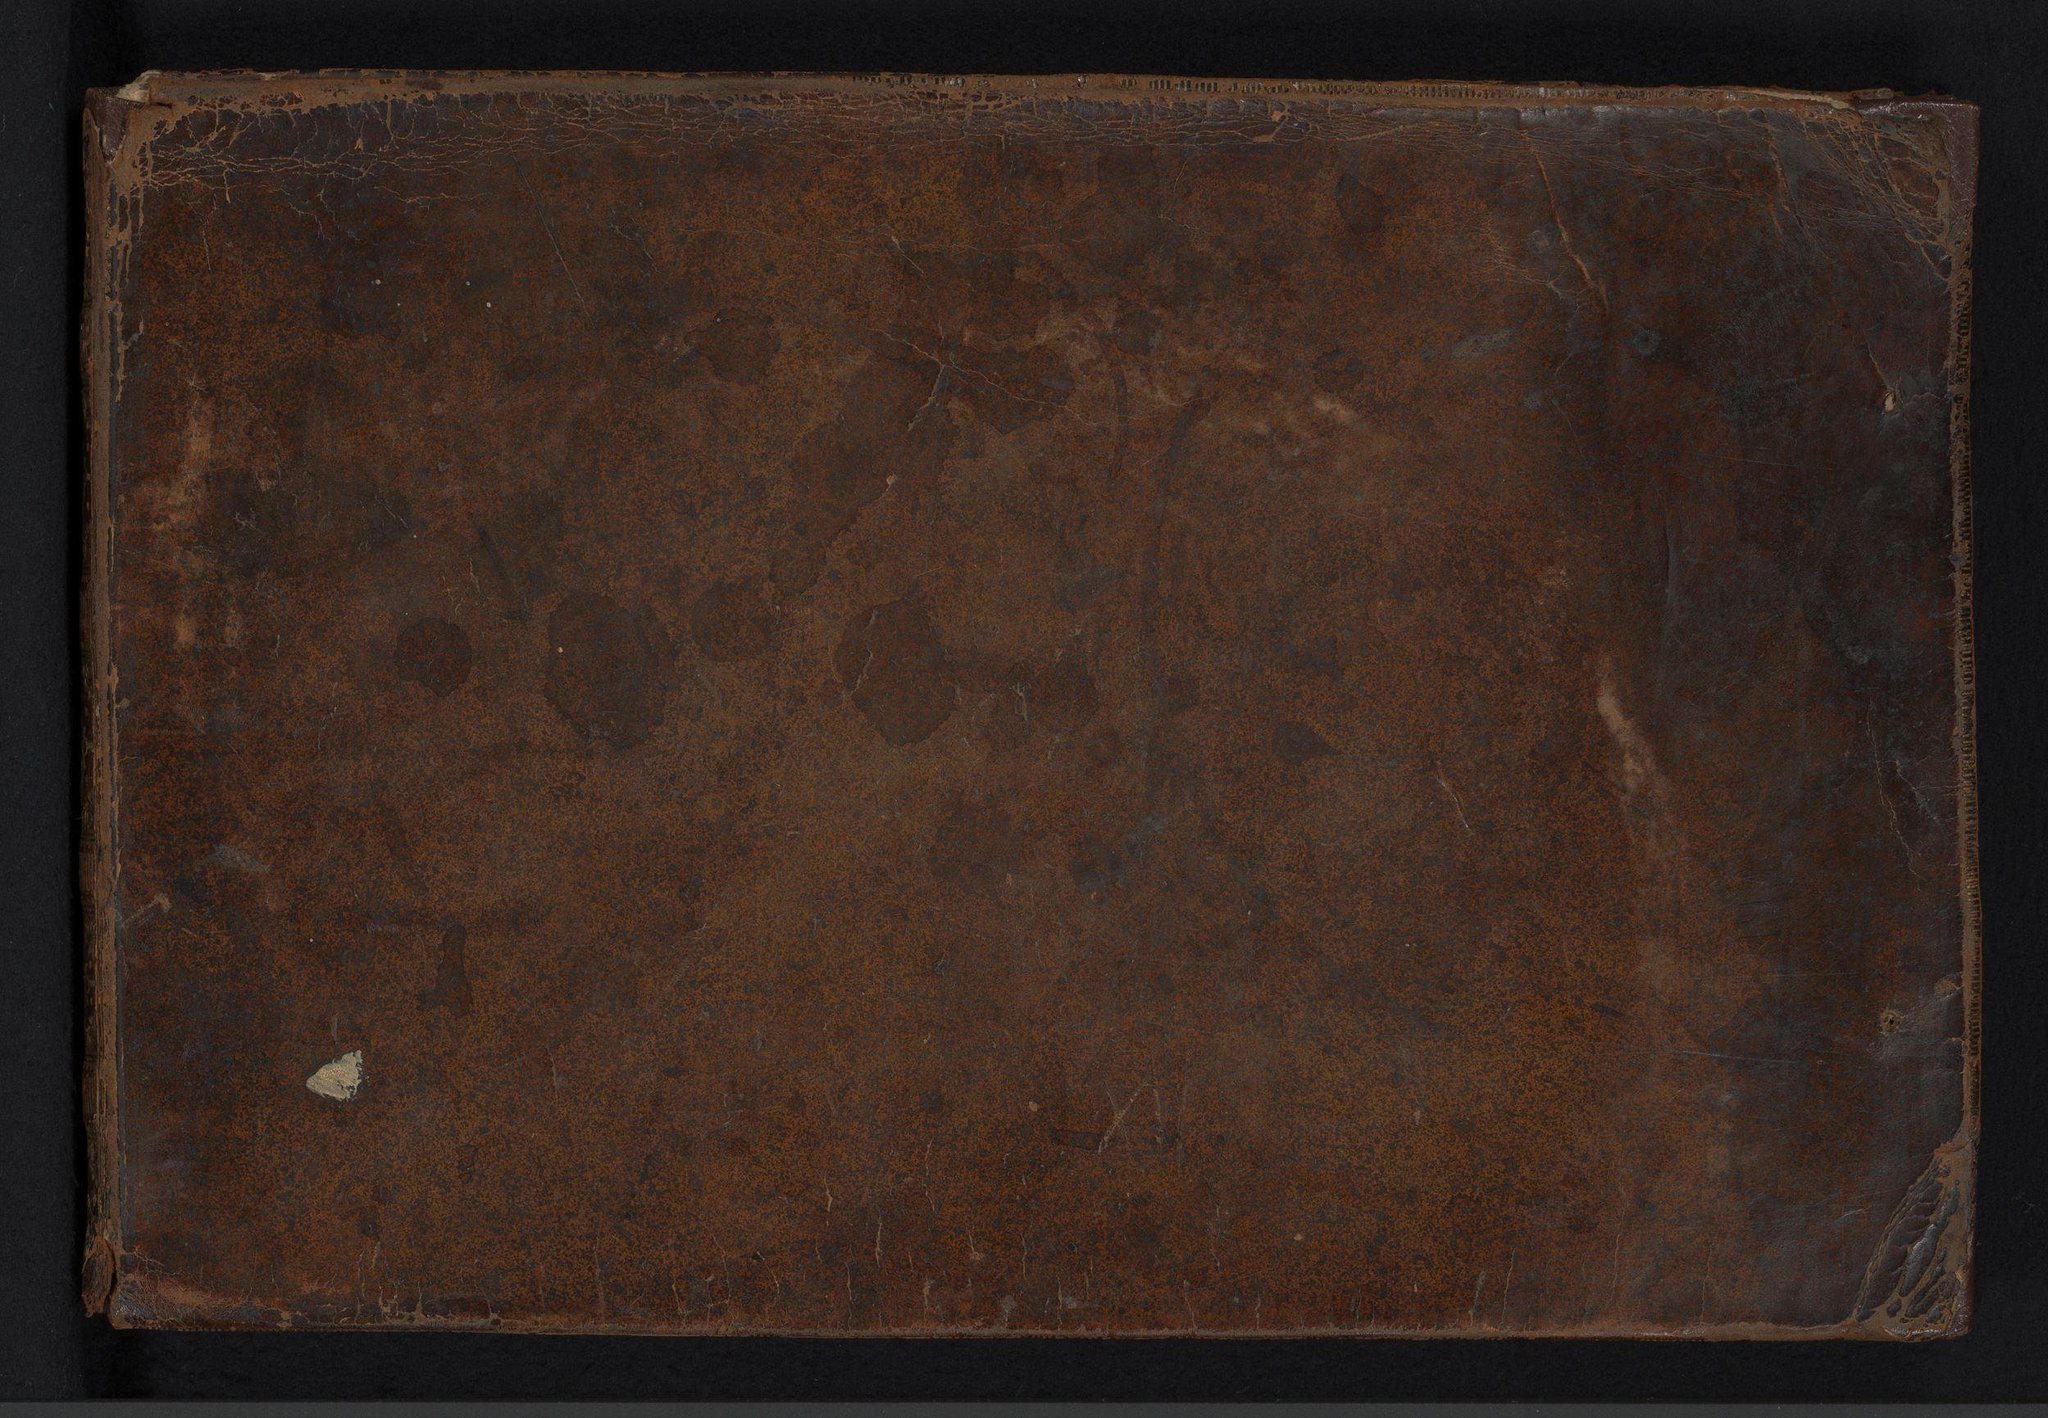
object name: prentrecueil, prentenalbum, prentalbum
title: Album met kalligrafische schrijfvoorbeelden van David Roelands en Cornelis Dirksz Boissens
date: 1628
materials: leather, paper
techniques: bookbinding, engraving, letterpress printing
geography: amsterdam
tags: calligraphy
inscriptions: collector's mark: Lugt 2166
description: Album met titelprent, tekstbladen en 65 schrijfvoorbeelden op 73 albumbladen. Het album bevat de titelprent, het voorwerk en 42 (van 44) schrijfvoorbeelden uit David Roelands' Magazin oft pac-huys der loffelycker penn-const, 1616. Toegevoegd is een schrijfvoorbeeld uit 1628, wellicht eveneens van Roelands. Daarna volgen 23 (van 48?) schrijfvoorbeelden uit Cornelis Dirksz Boissens' Grammato-Graphices, 1605. Bruin leren band met voorin en achterin enkele schutbladen.